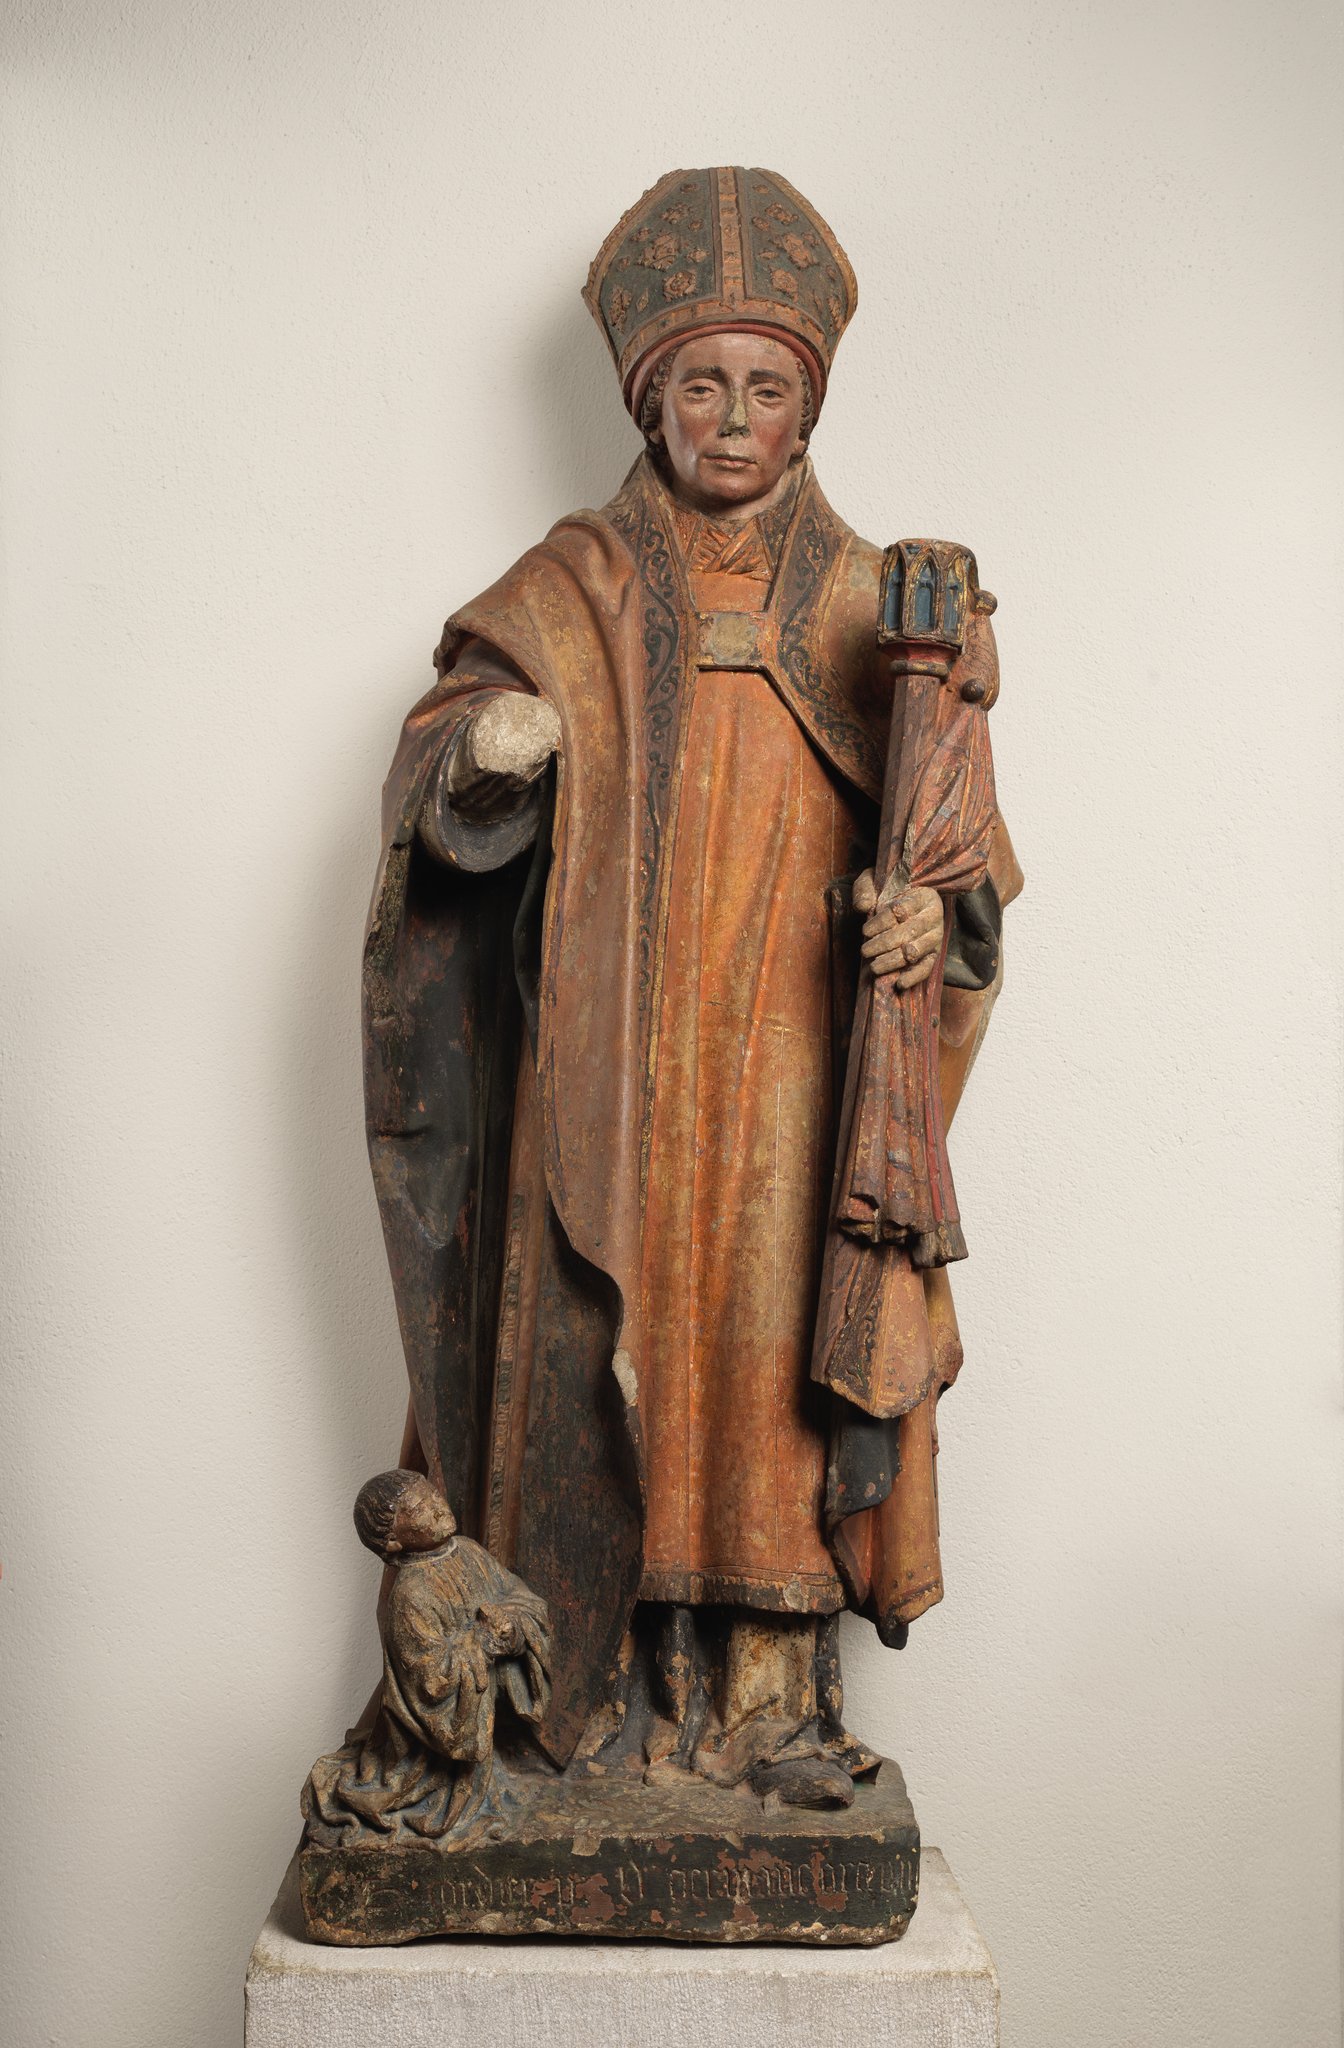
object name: statue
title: Saint Germain and a Donor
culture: french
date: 1467-1500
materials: limestone, paint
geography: france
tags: men,saints